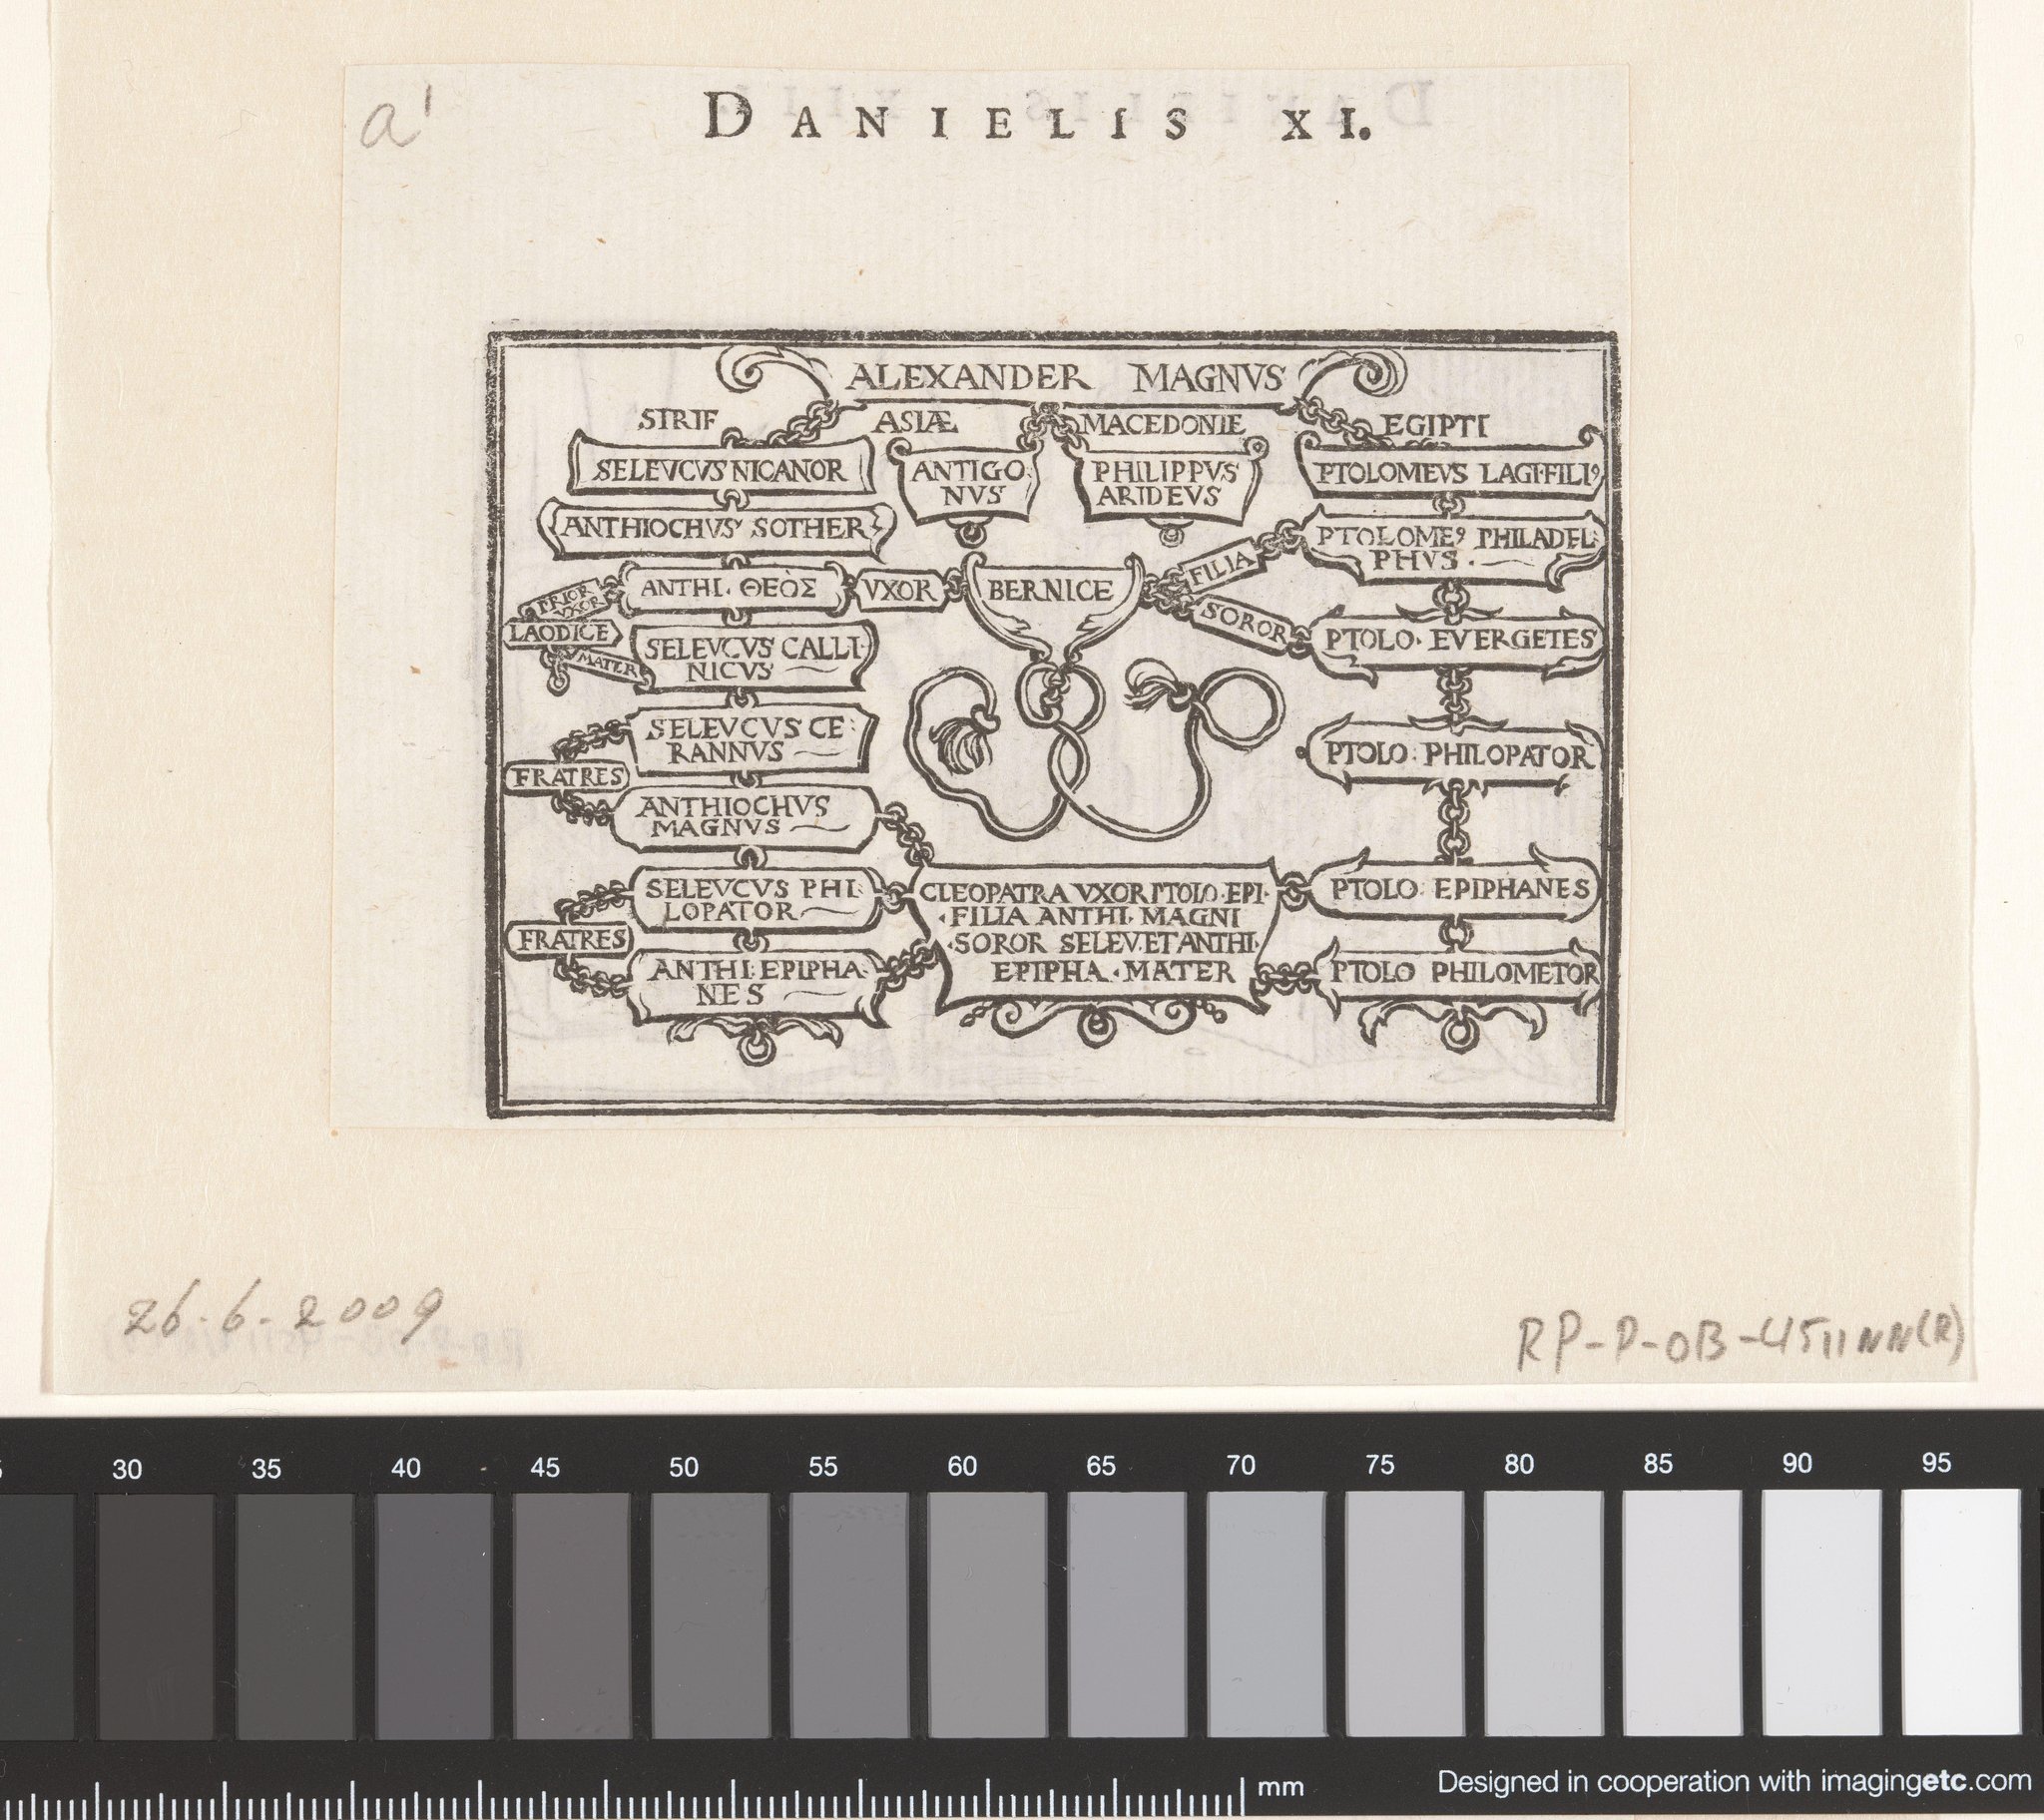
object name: print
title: Stamboom van de Seleuciden en de Ptolemeeën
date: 1538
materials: paper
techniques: woodcut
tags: family lineage, pedigree, genealogical tree or table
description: Stamboom van de opvolgers van Alexander de Grote, de Seleuciden en de Ptolemeeën, welke heersten over de gebieden van het huidige Syrië en Egypte. In de marge boven de afbeelding staat de tekst Danielis XI.